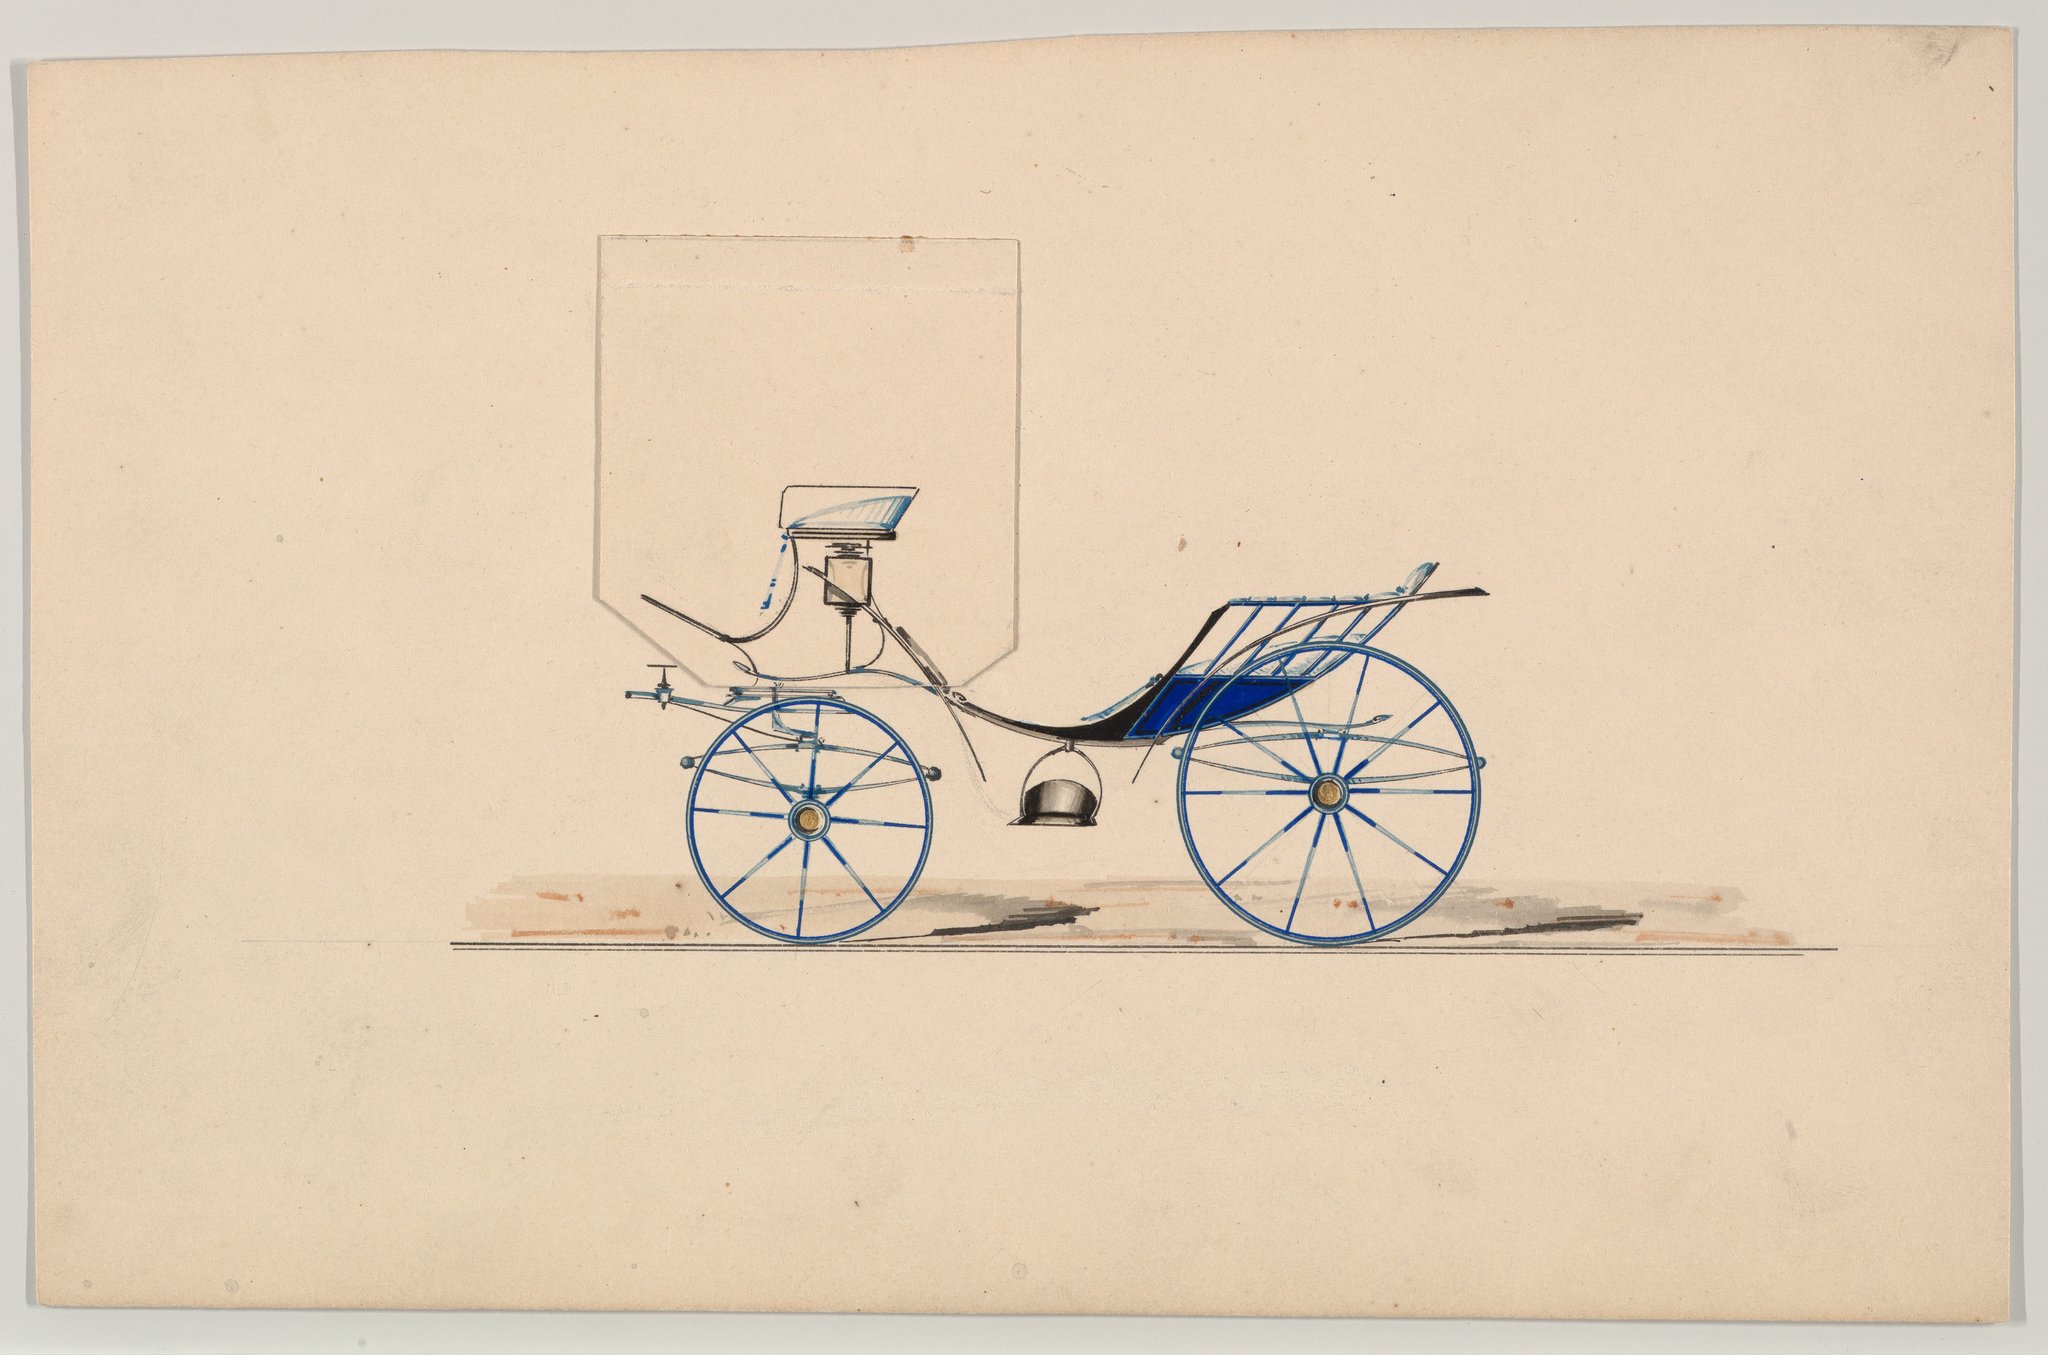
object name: drawing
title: Stick Seat Phaeton (unnumbered)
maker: brewster & co.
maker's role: manufacturer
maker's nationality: american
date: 1870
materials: gouache, gum arabic, ink, watercolor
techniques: pen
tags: carriages